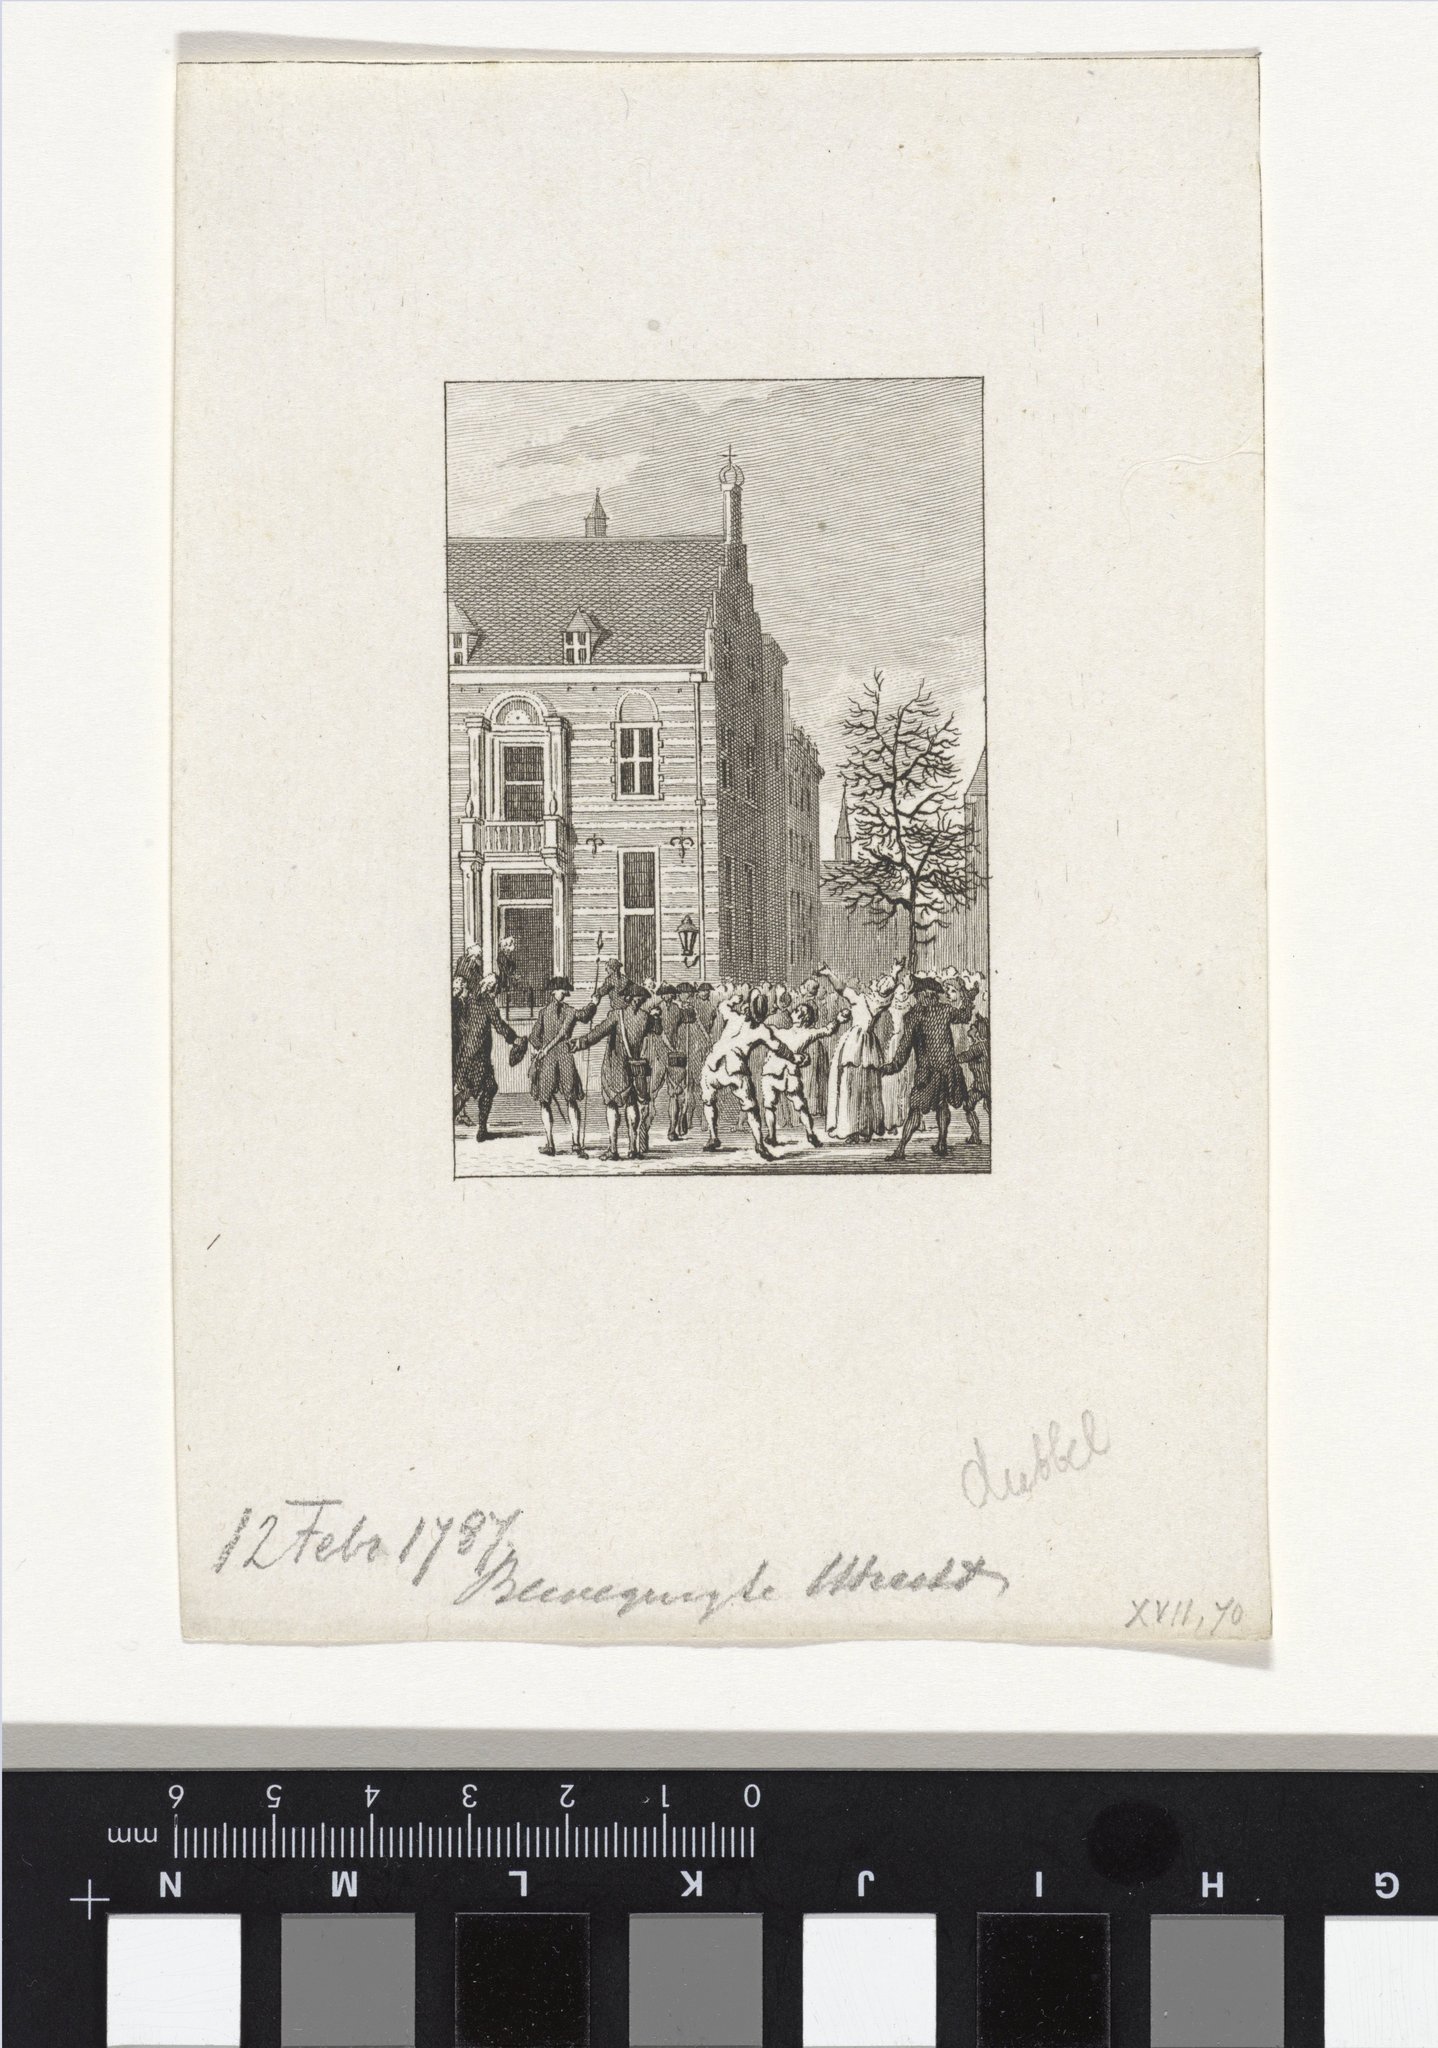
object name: print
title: Onrust te Utrecht, 1787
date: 1751-1817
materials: paper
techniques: engraving, etching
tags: street-fights, riots, utrecht, patriots (1780-1795)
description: Gebruikt als illustratie in: J. Fokke, Geschiedenissen der Vereenigde Nederlanden voor de vaderlandsche jeugd, Johannes Allart, Amsterdam 1783-1795, 25 delen, dl. 17, pl. 3.